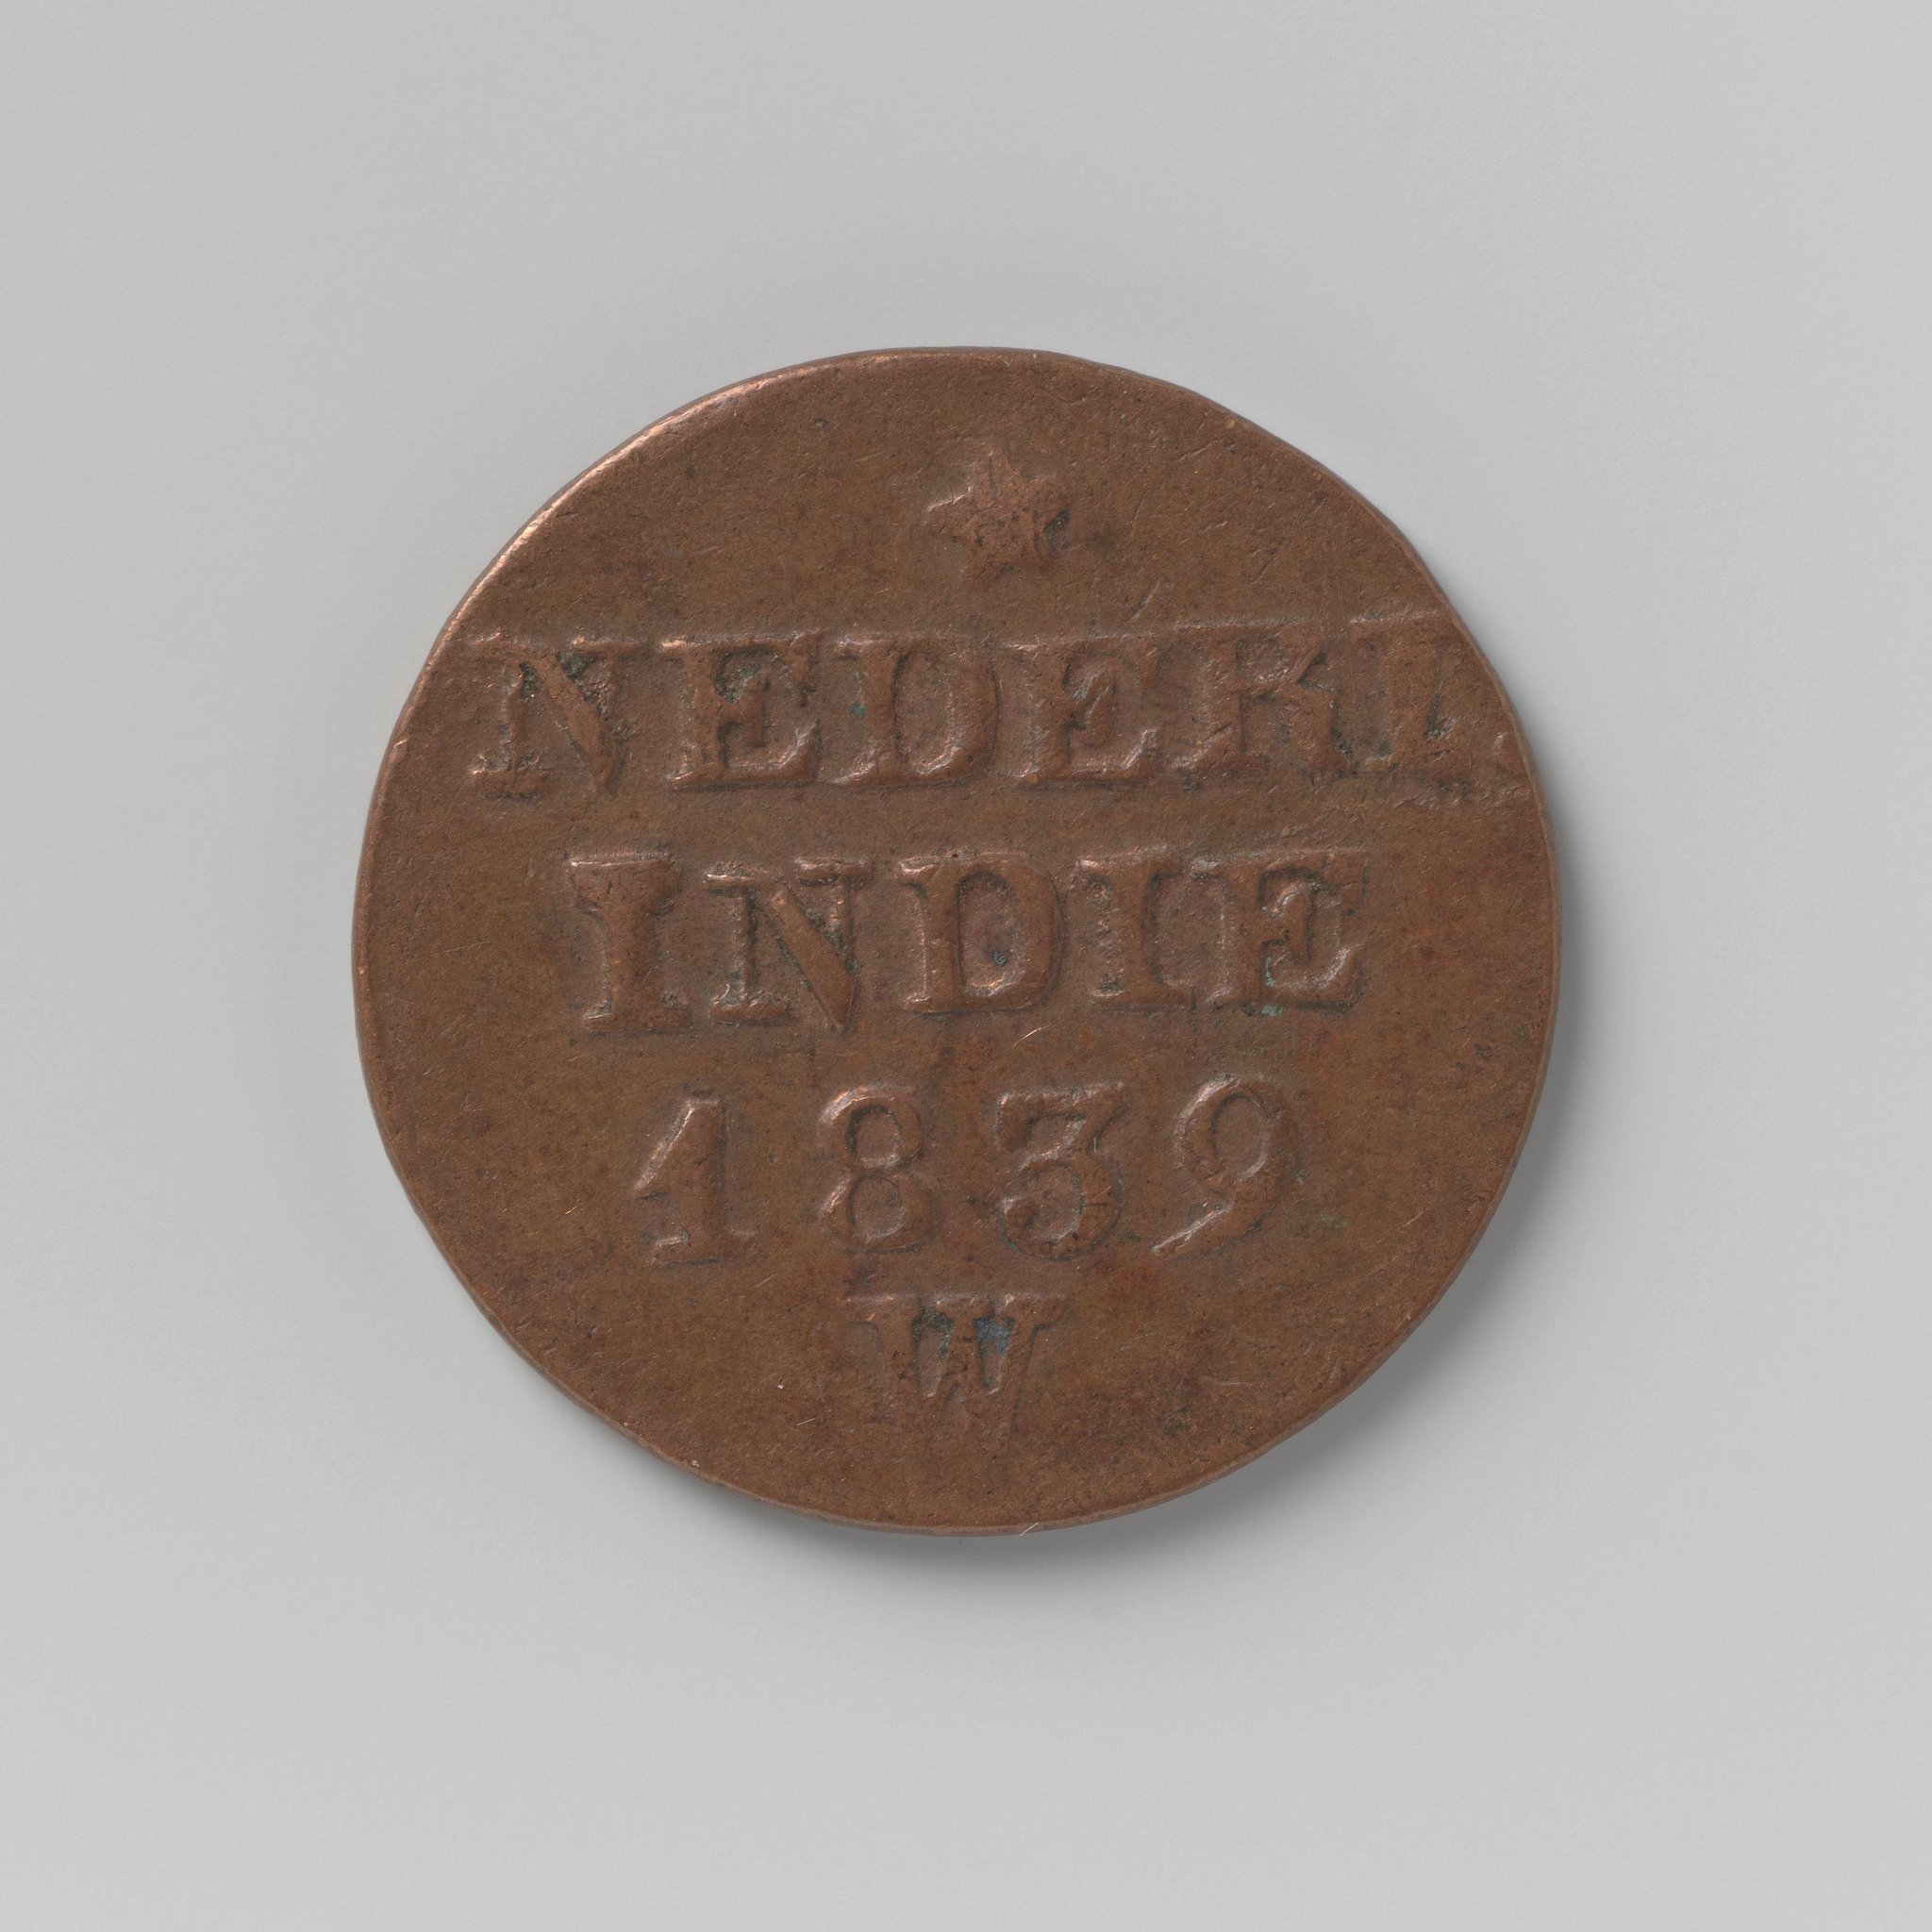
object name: coin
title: Nederlands Indië, cent,1839 W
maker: william i of the netherlands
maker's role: koning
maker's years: 1772-1843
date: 1839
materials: copper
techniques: striking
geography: surabaya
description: Koperen munt. Voorzijde: tussen waarde-aanduiding I CT. gekroond rijkswapenschild. Keerzijde: tweeregelig opschrift, waarboven muntteken en waaronder jaartal. Daaronder letter W [=muntmeester Wilmans]. Gladde rand.